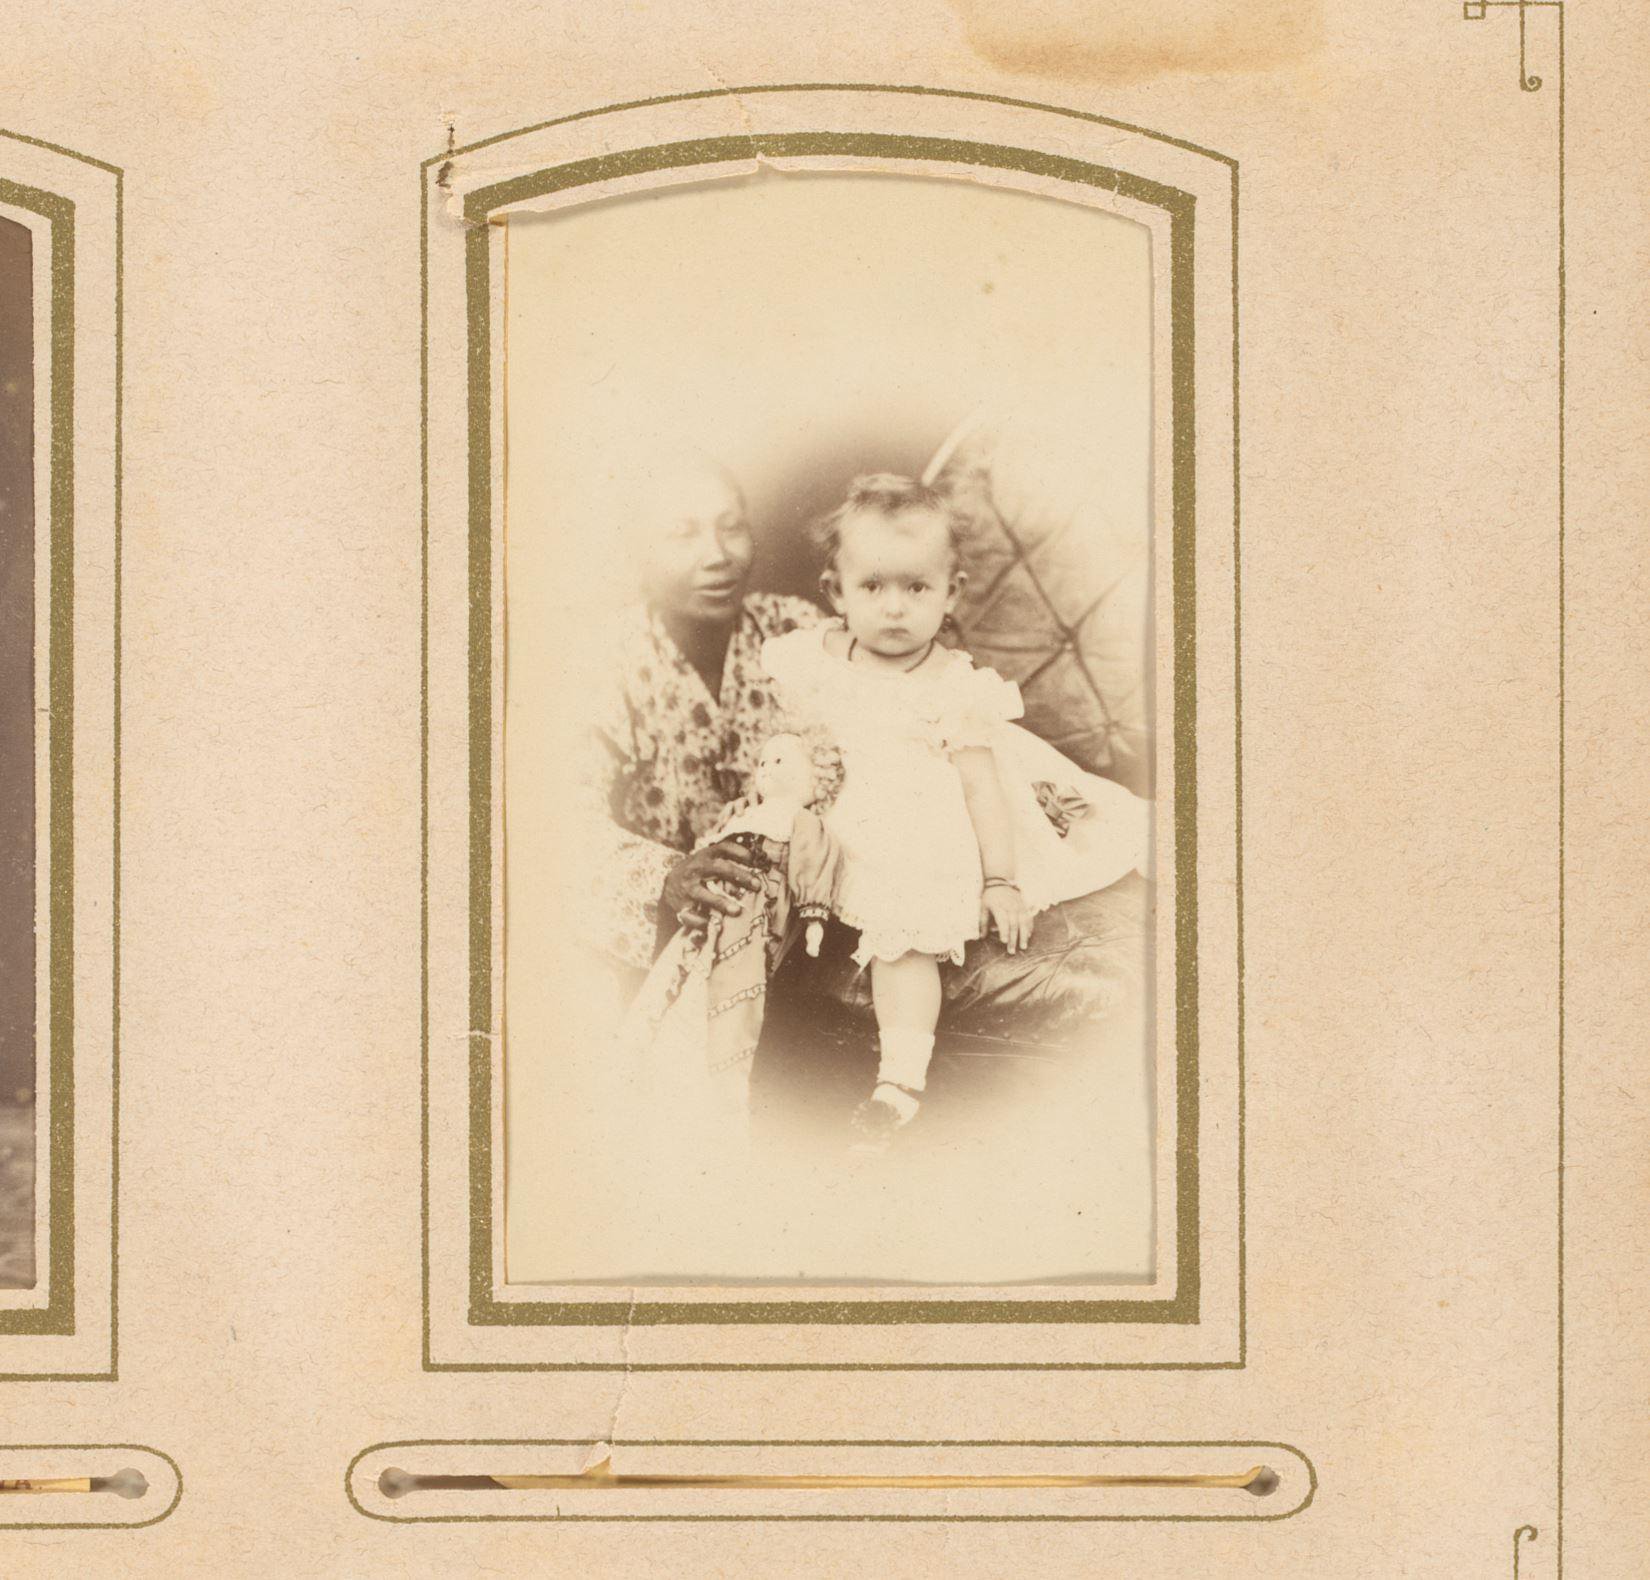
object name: carte de visite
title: Portret van Jacqueline Mahie, anderhalf jaar oud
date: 1872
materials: cardboard, photographic support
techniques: albumen print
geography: java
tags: historical persons - bb - woman, toddler (female)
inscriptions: inscription: ‘WOODBURY & PAGE,/ PHOTOGRAPHERS/ JAVA.’, annotation: ‘Jacqueline Mahie Batavia/ oud anderhalf jaar. 1872’